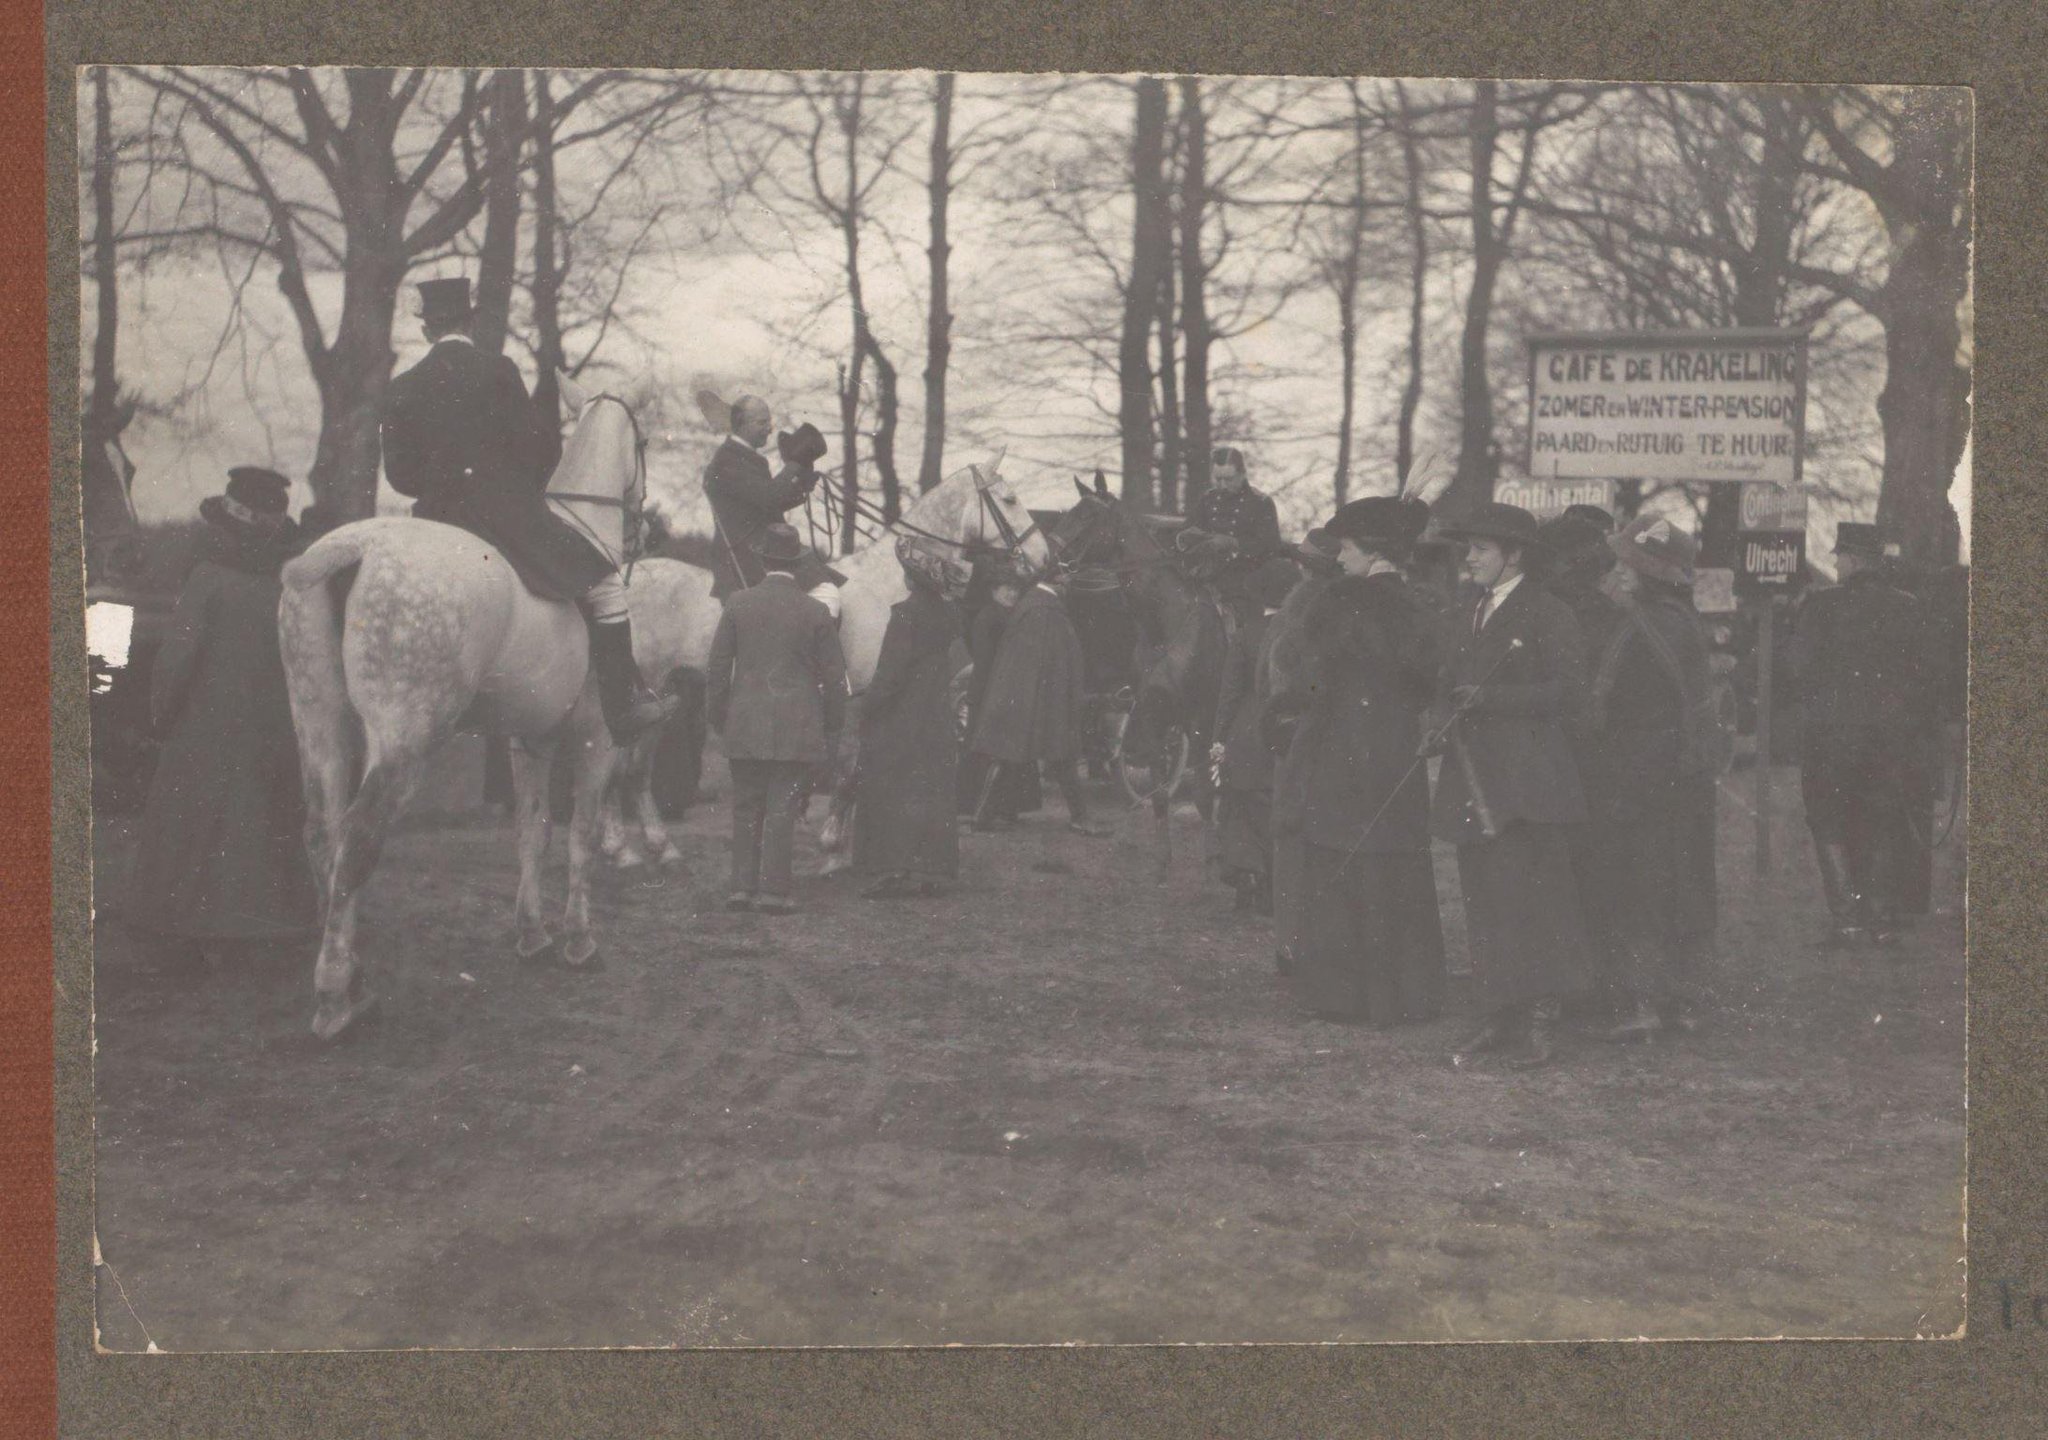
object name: album leaf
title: Ruitertafereel op Koninklijke Houtvesterij Het Loo: gezelschap en ruiters bij café de Krakeling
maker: Anonymous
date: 1900-1925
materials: photographic support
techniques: gelatin silver print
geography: het loo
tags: riding a horse, ass, or mule; rider, horseman, advertising, hunting, chase, hunting-ground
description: Onderdeel van Fotoalbum van de heer Brams, opperhoutvester van koningin Wilhelmina op Koninklijke Houtvesterij Het Loo.